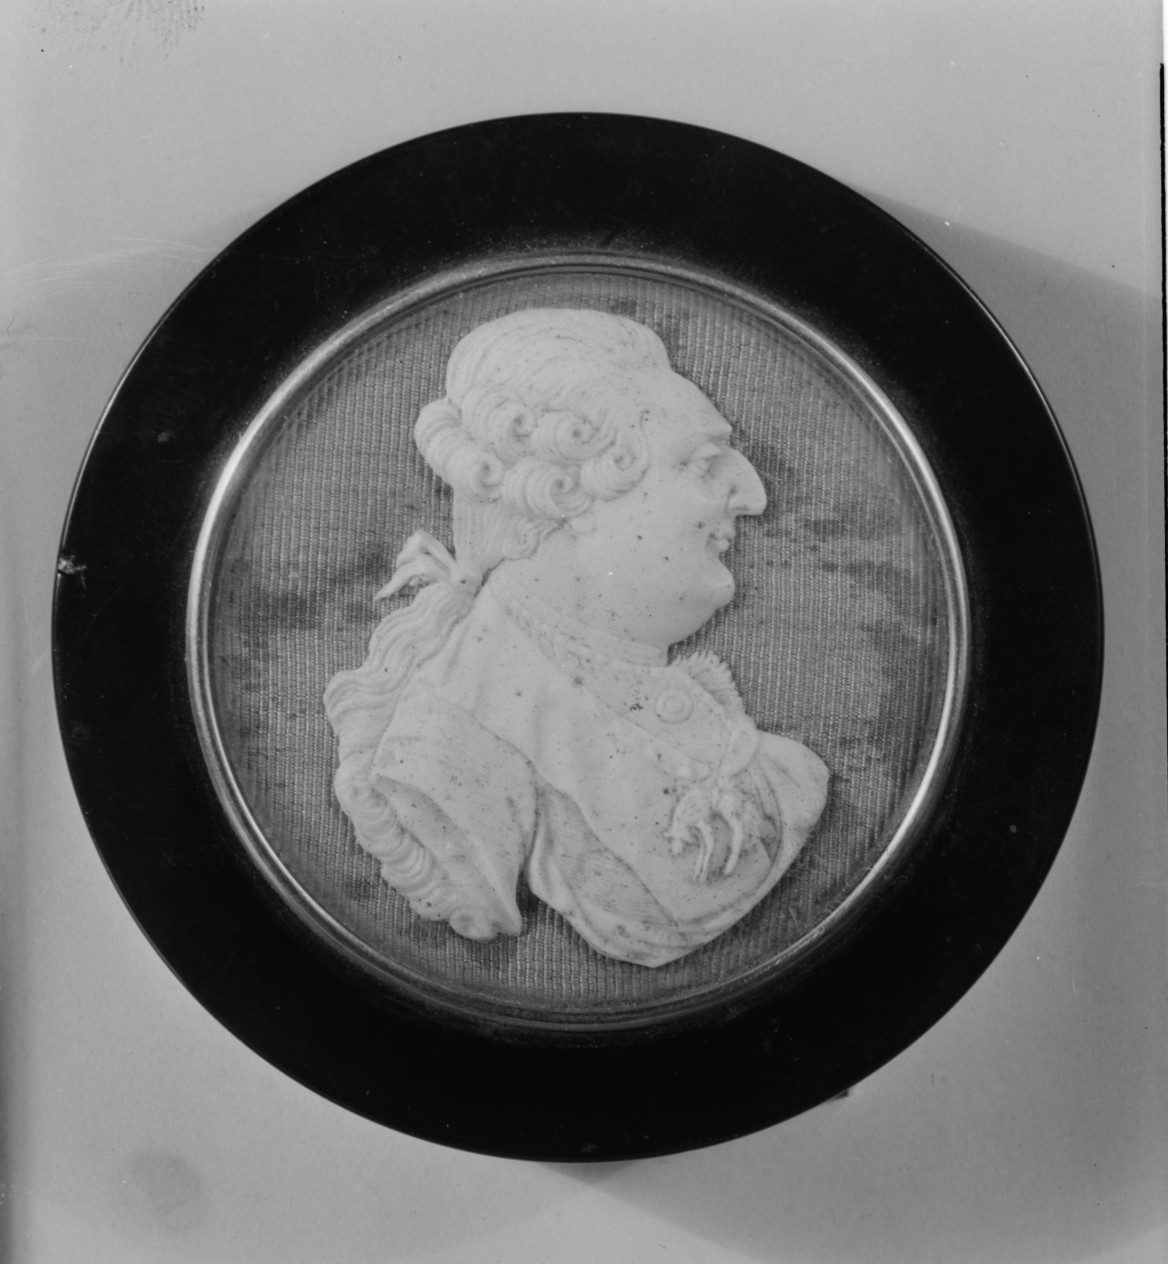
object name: box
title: Louis XVI (1754–1793)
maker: philippe curtius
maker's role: maker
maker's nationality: swiss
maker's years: 1737-1794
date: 1785-1790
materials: glass, silk, shell, wax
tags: kings,men,profiles